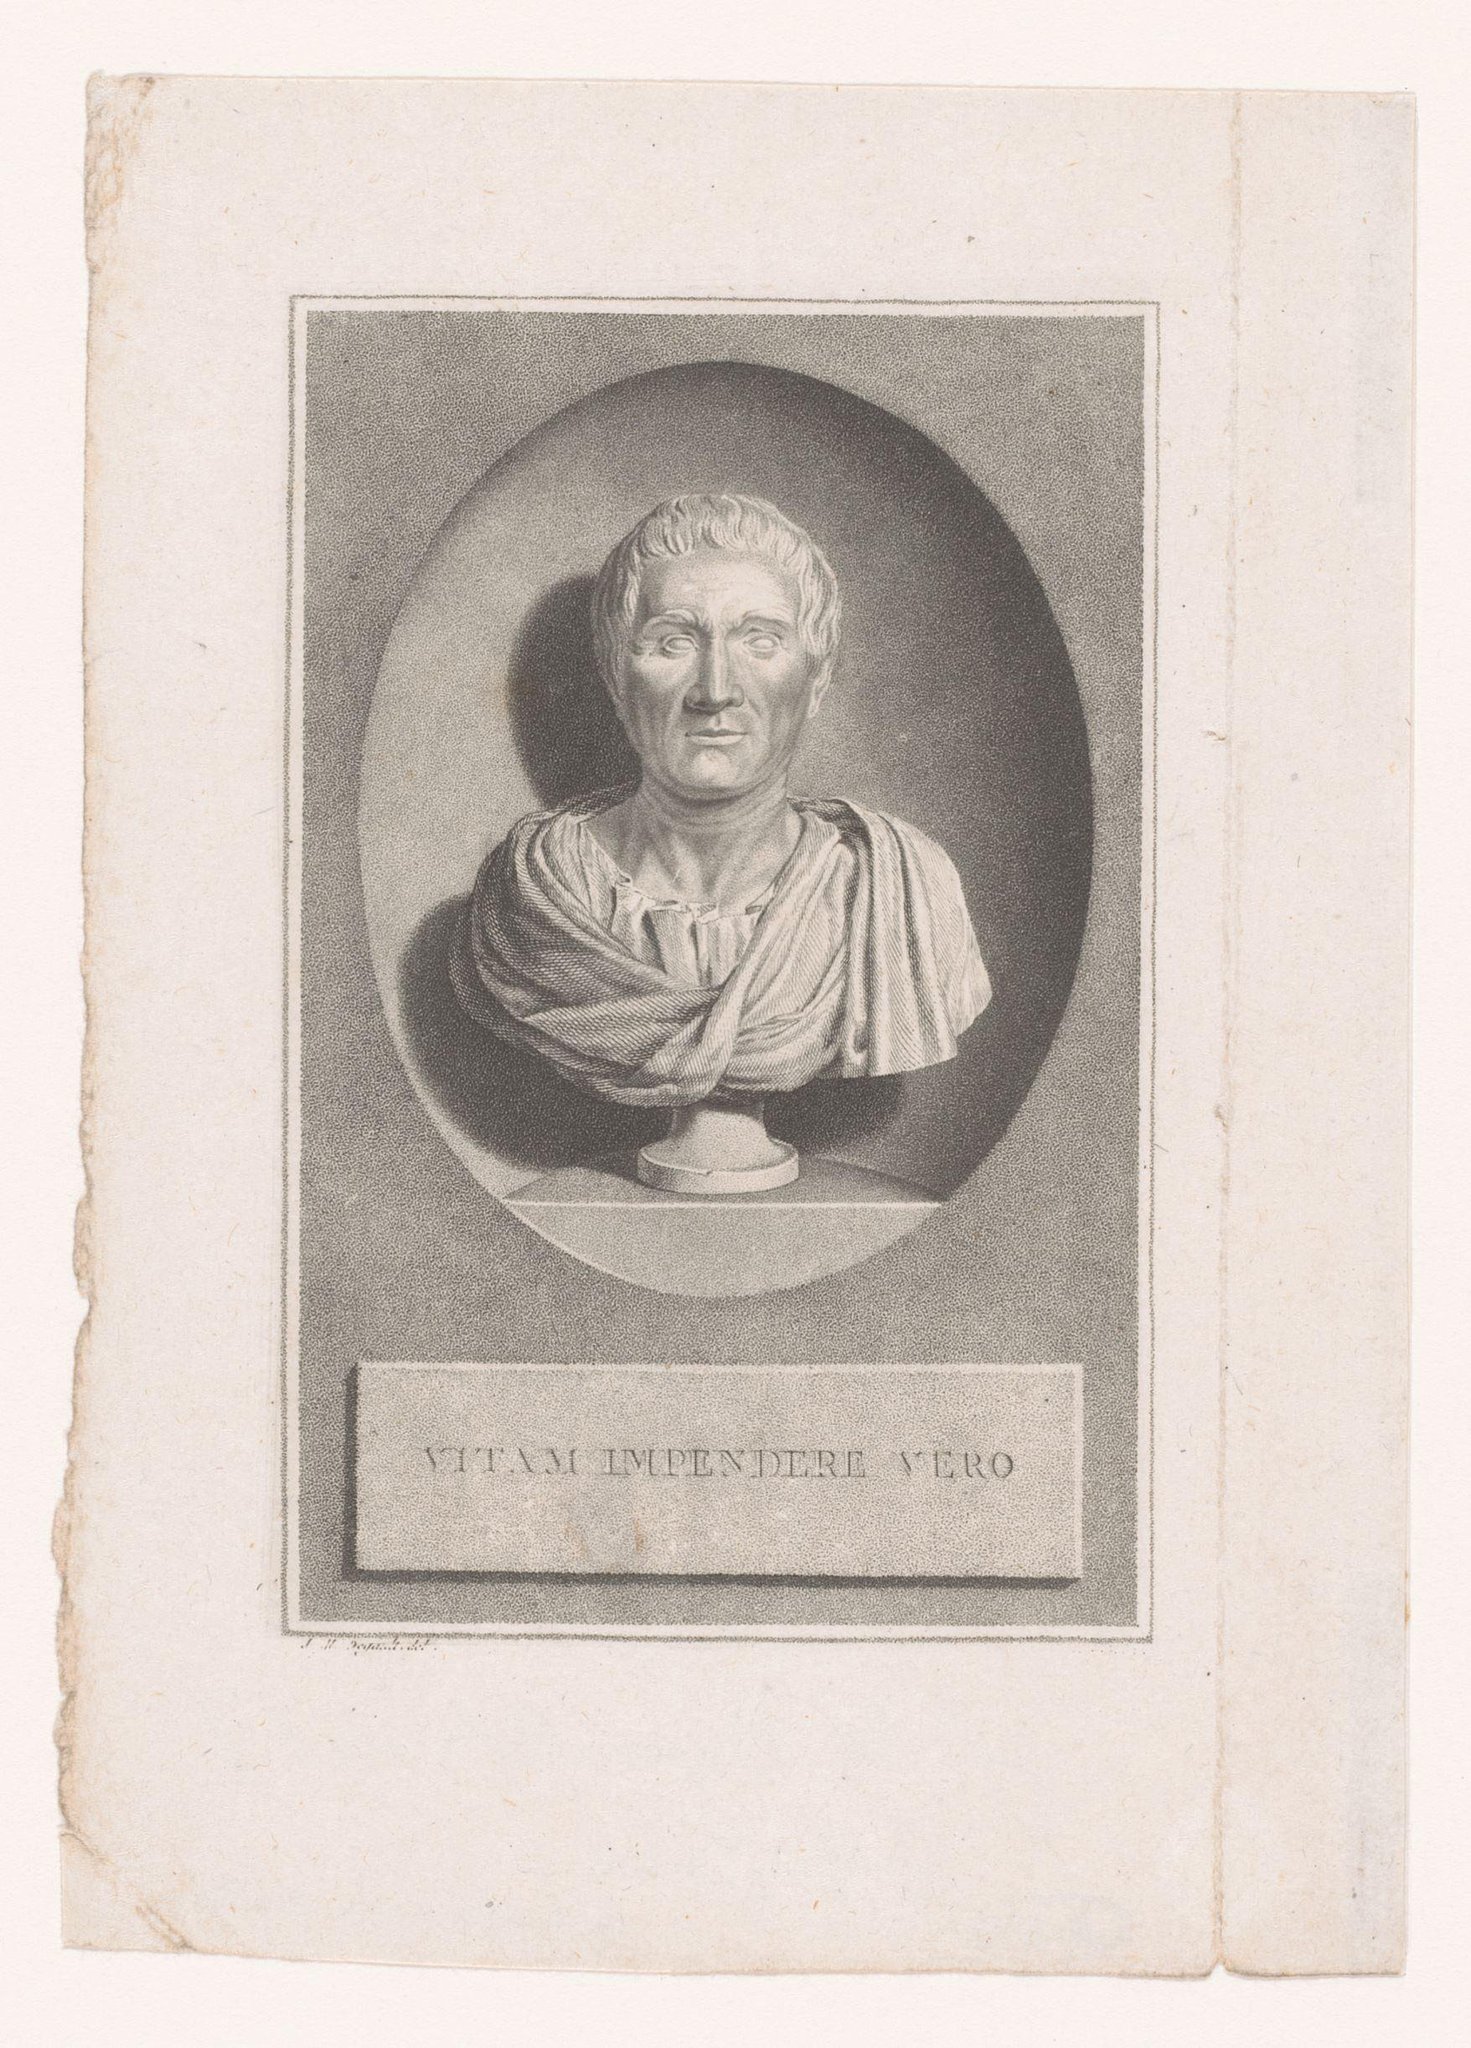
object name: print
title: Vitam Impendere Vero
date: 1808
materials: paper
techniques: etching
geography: paris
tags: historical persons, portrait of a writer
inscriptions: collector's mark: Lugt 2228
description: Prent uit: Rousseau, Jean-Jacques. La nouvelle Heloïse (...). Parijs: Bossange, Masson & Besson e.a., 1808.